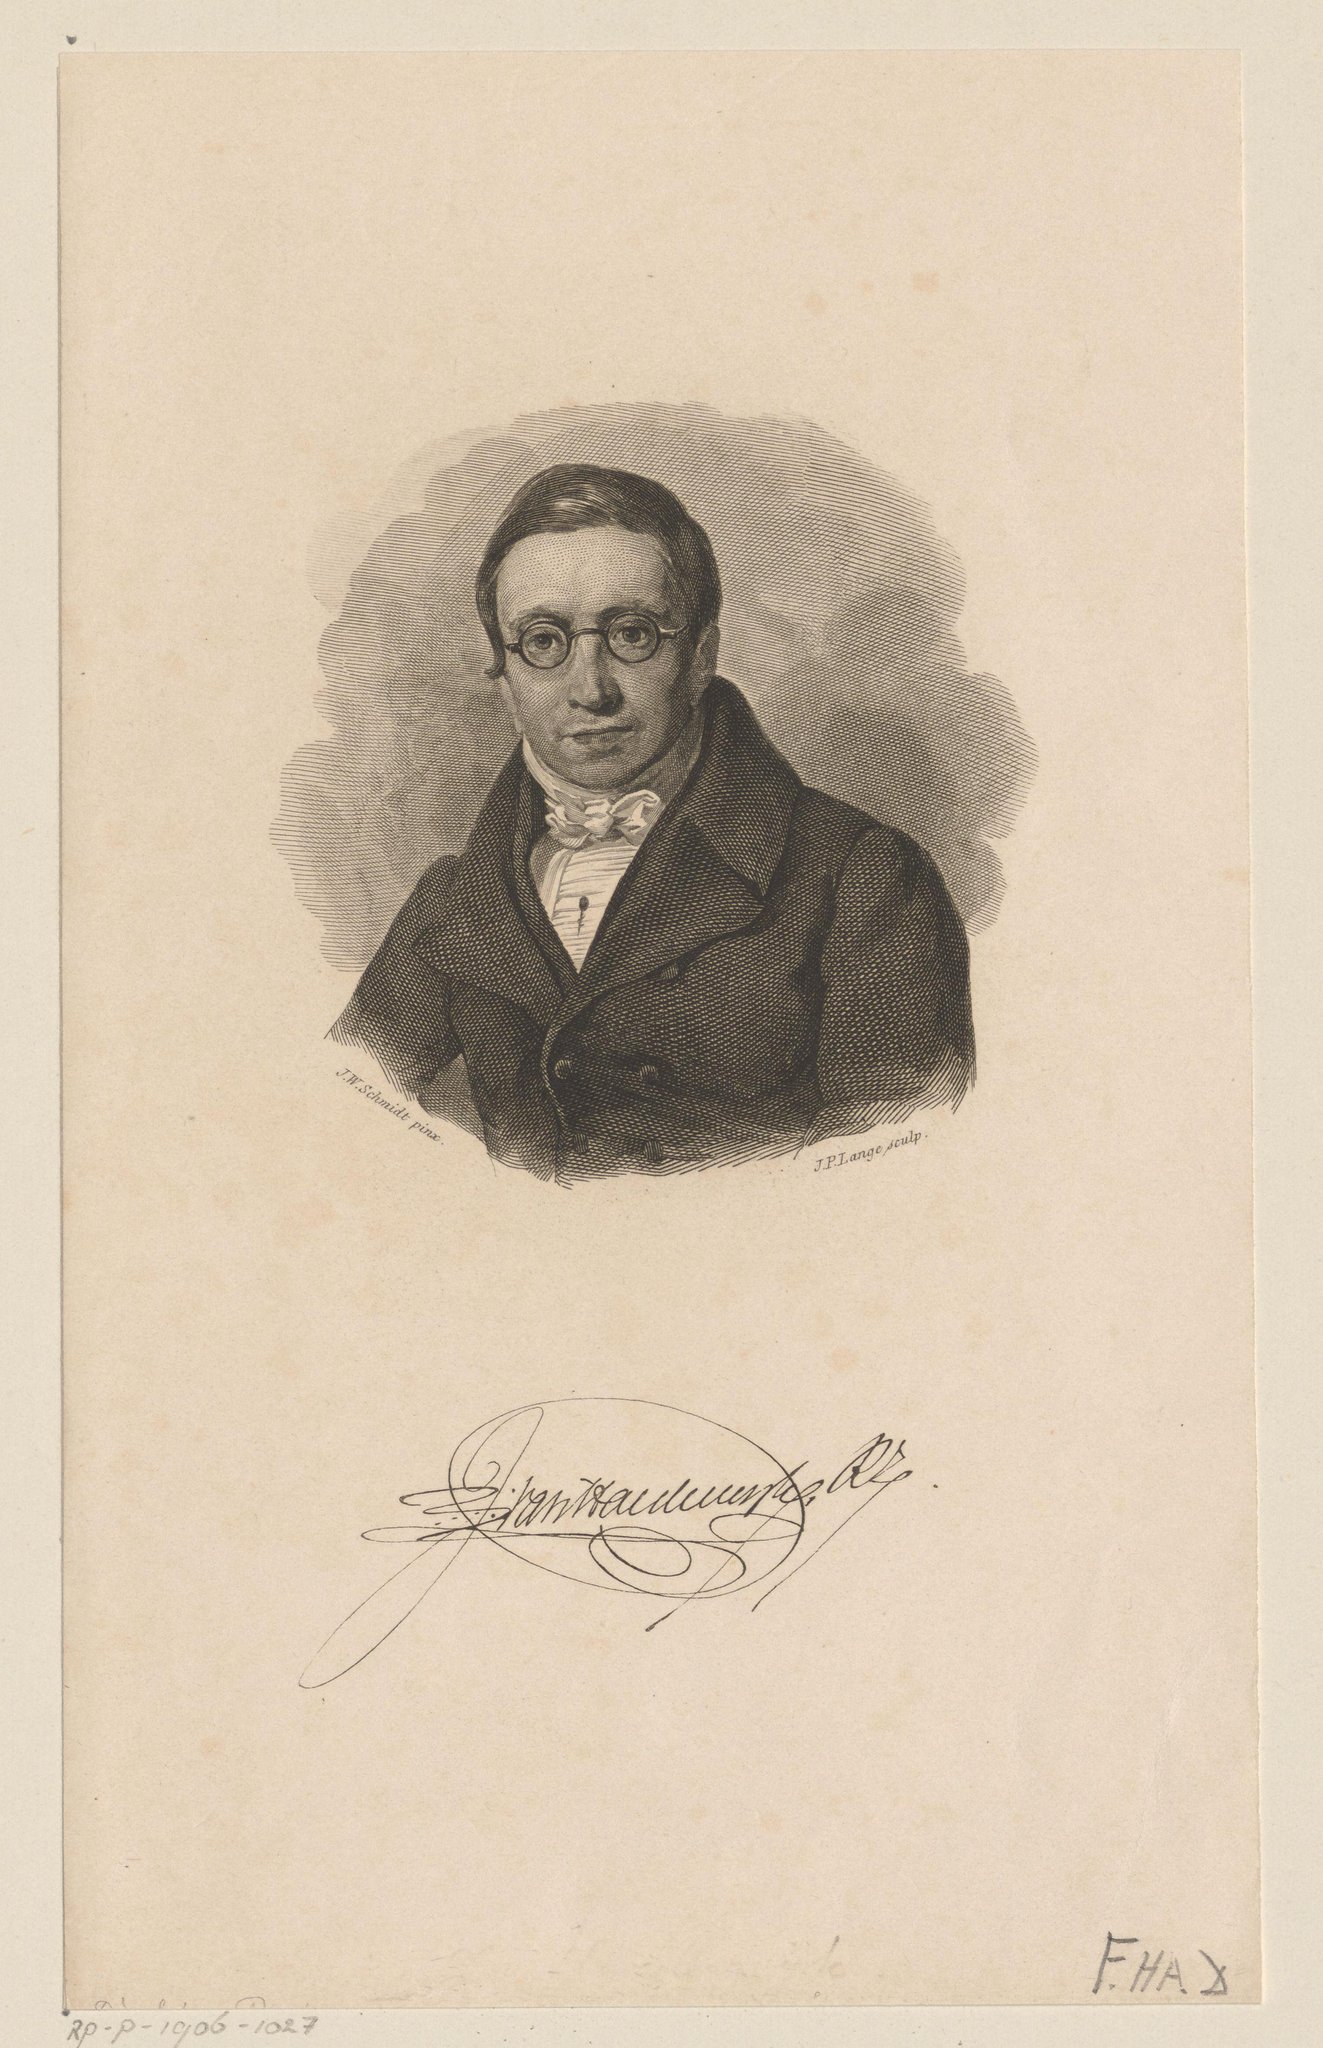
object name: book illustration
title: Portret van Jan van Harderwijk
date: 1840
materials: paper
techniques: engraving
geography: amsterdam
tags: rotterdam, draughtsman, jan van harderwijk, eyeglasses, spectacles, historical persons, portrait, self-portrait of artist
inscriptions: collector's mark: Lugt 2228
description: Prent uit: Nederlandsche muziek-almanak voor 1840. Amsterdam: J.H. Laarman, 1840.